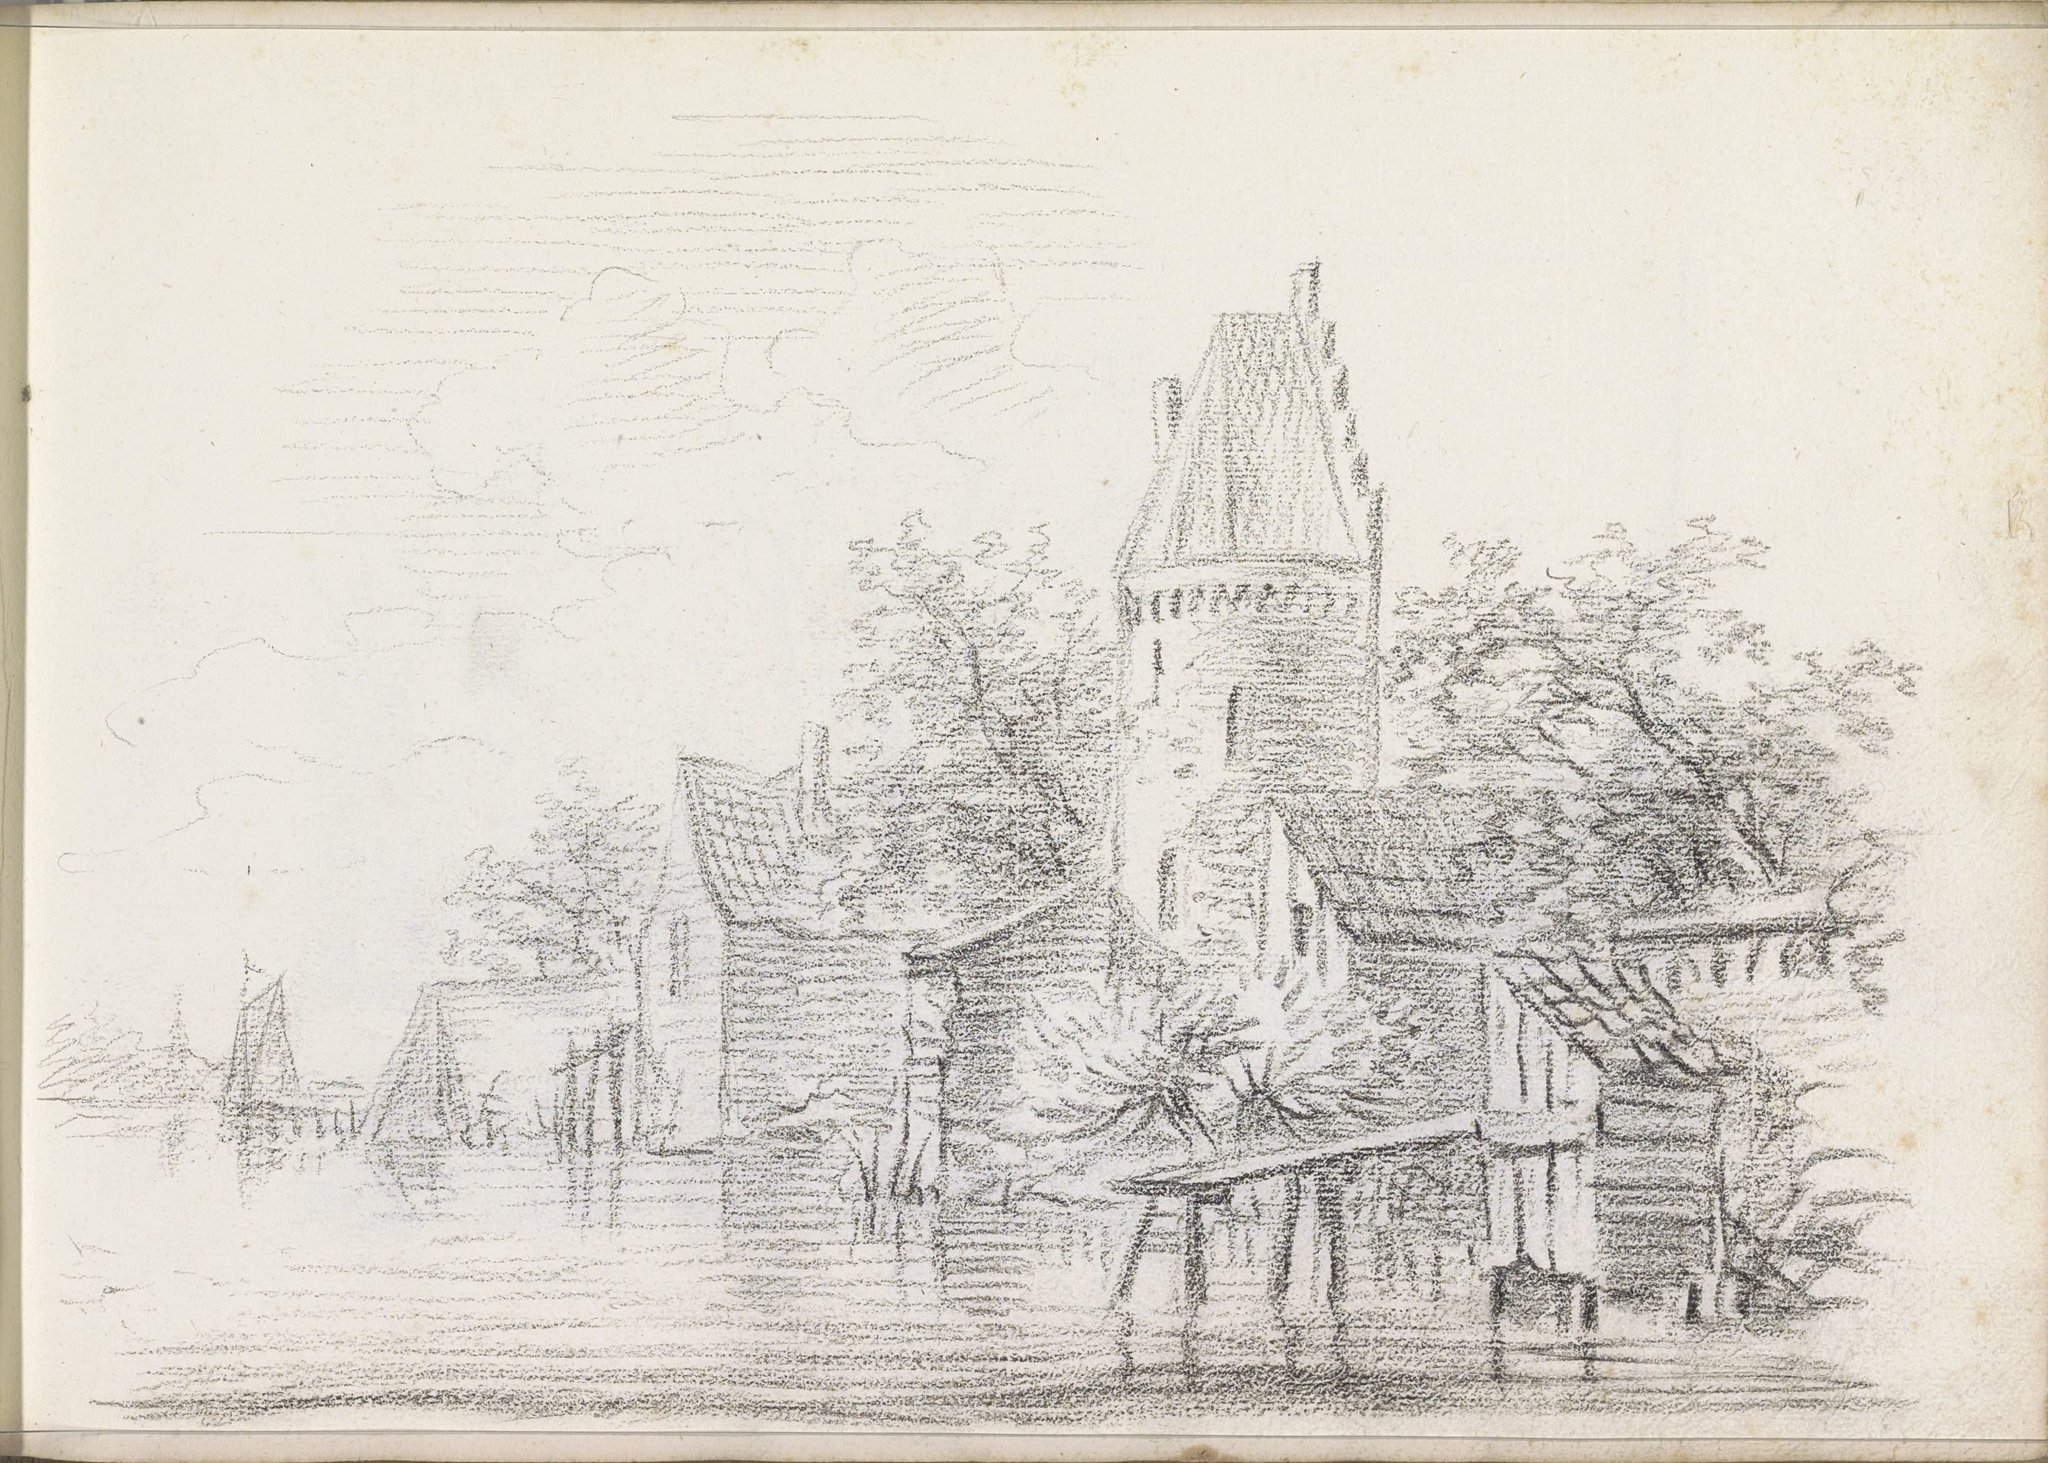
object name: sketchbook leaf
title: Huizen aan een waterkant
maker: andreas schelfhout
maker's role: draughtsman, painter, print maker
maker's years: 1787-1870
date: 1811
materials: chalk, paper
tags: landscapes with waters, waterscapes, seascapes (in the temperate zone), rural housing, e.g. country-house, villa, cottage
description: Tussen de huizen staan een toren en een steiger. Blad 16 recto uit een schetsboek met 75 bladen.